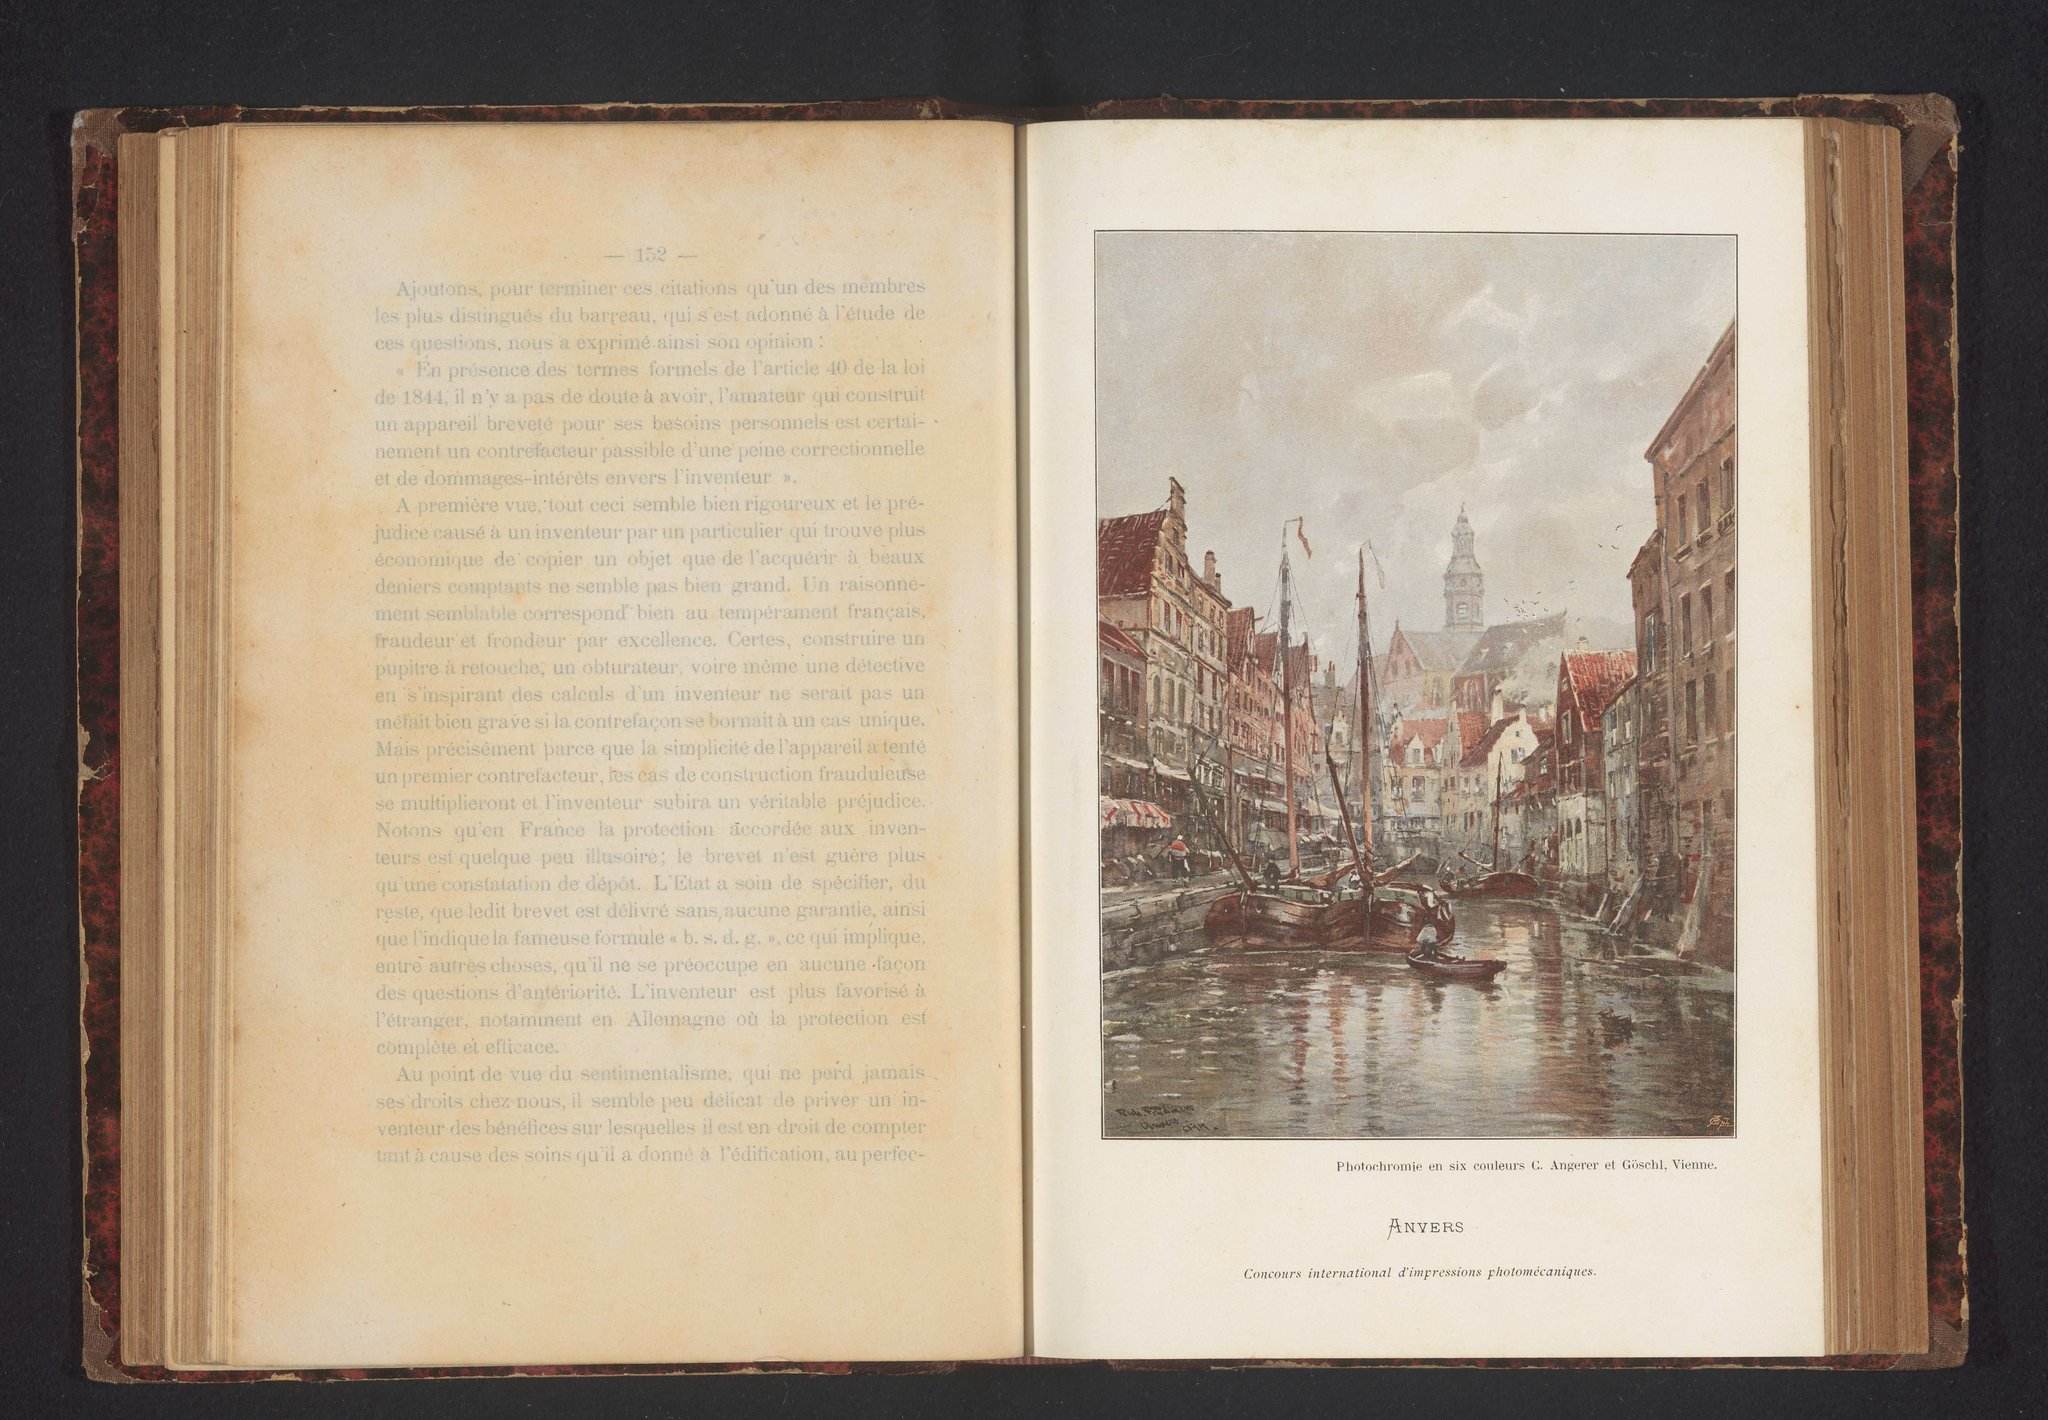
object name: page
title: Anvers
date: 1890-1895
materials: paper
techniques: autotype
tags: sailing-ship, sailing-boat, city-view in general; 'veduta', river, front façade, antwerp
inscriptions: inscription: ‘Concours international d'impressions photomécaniques.’